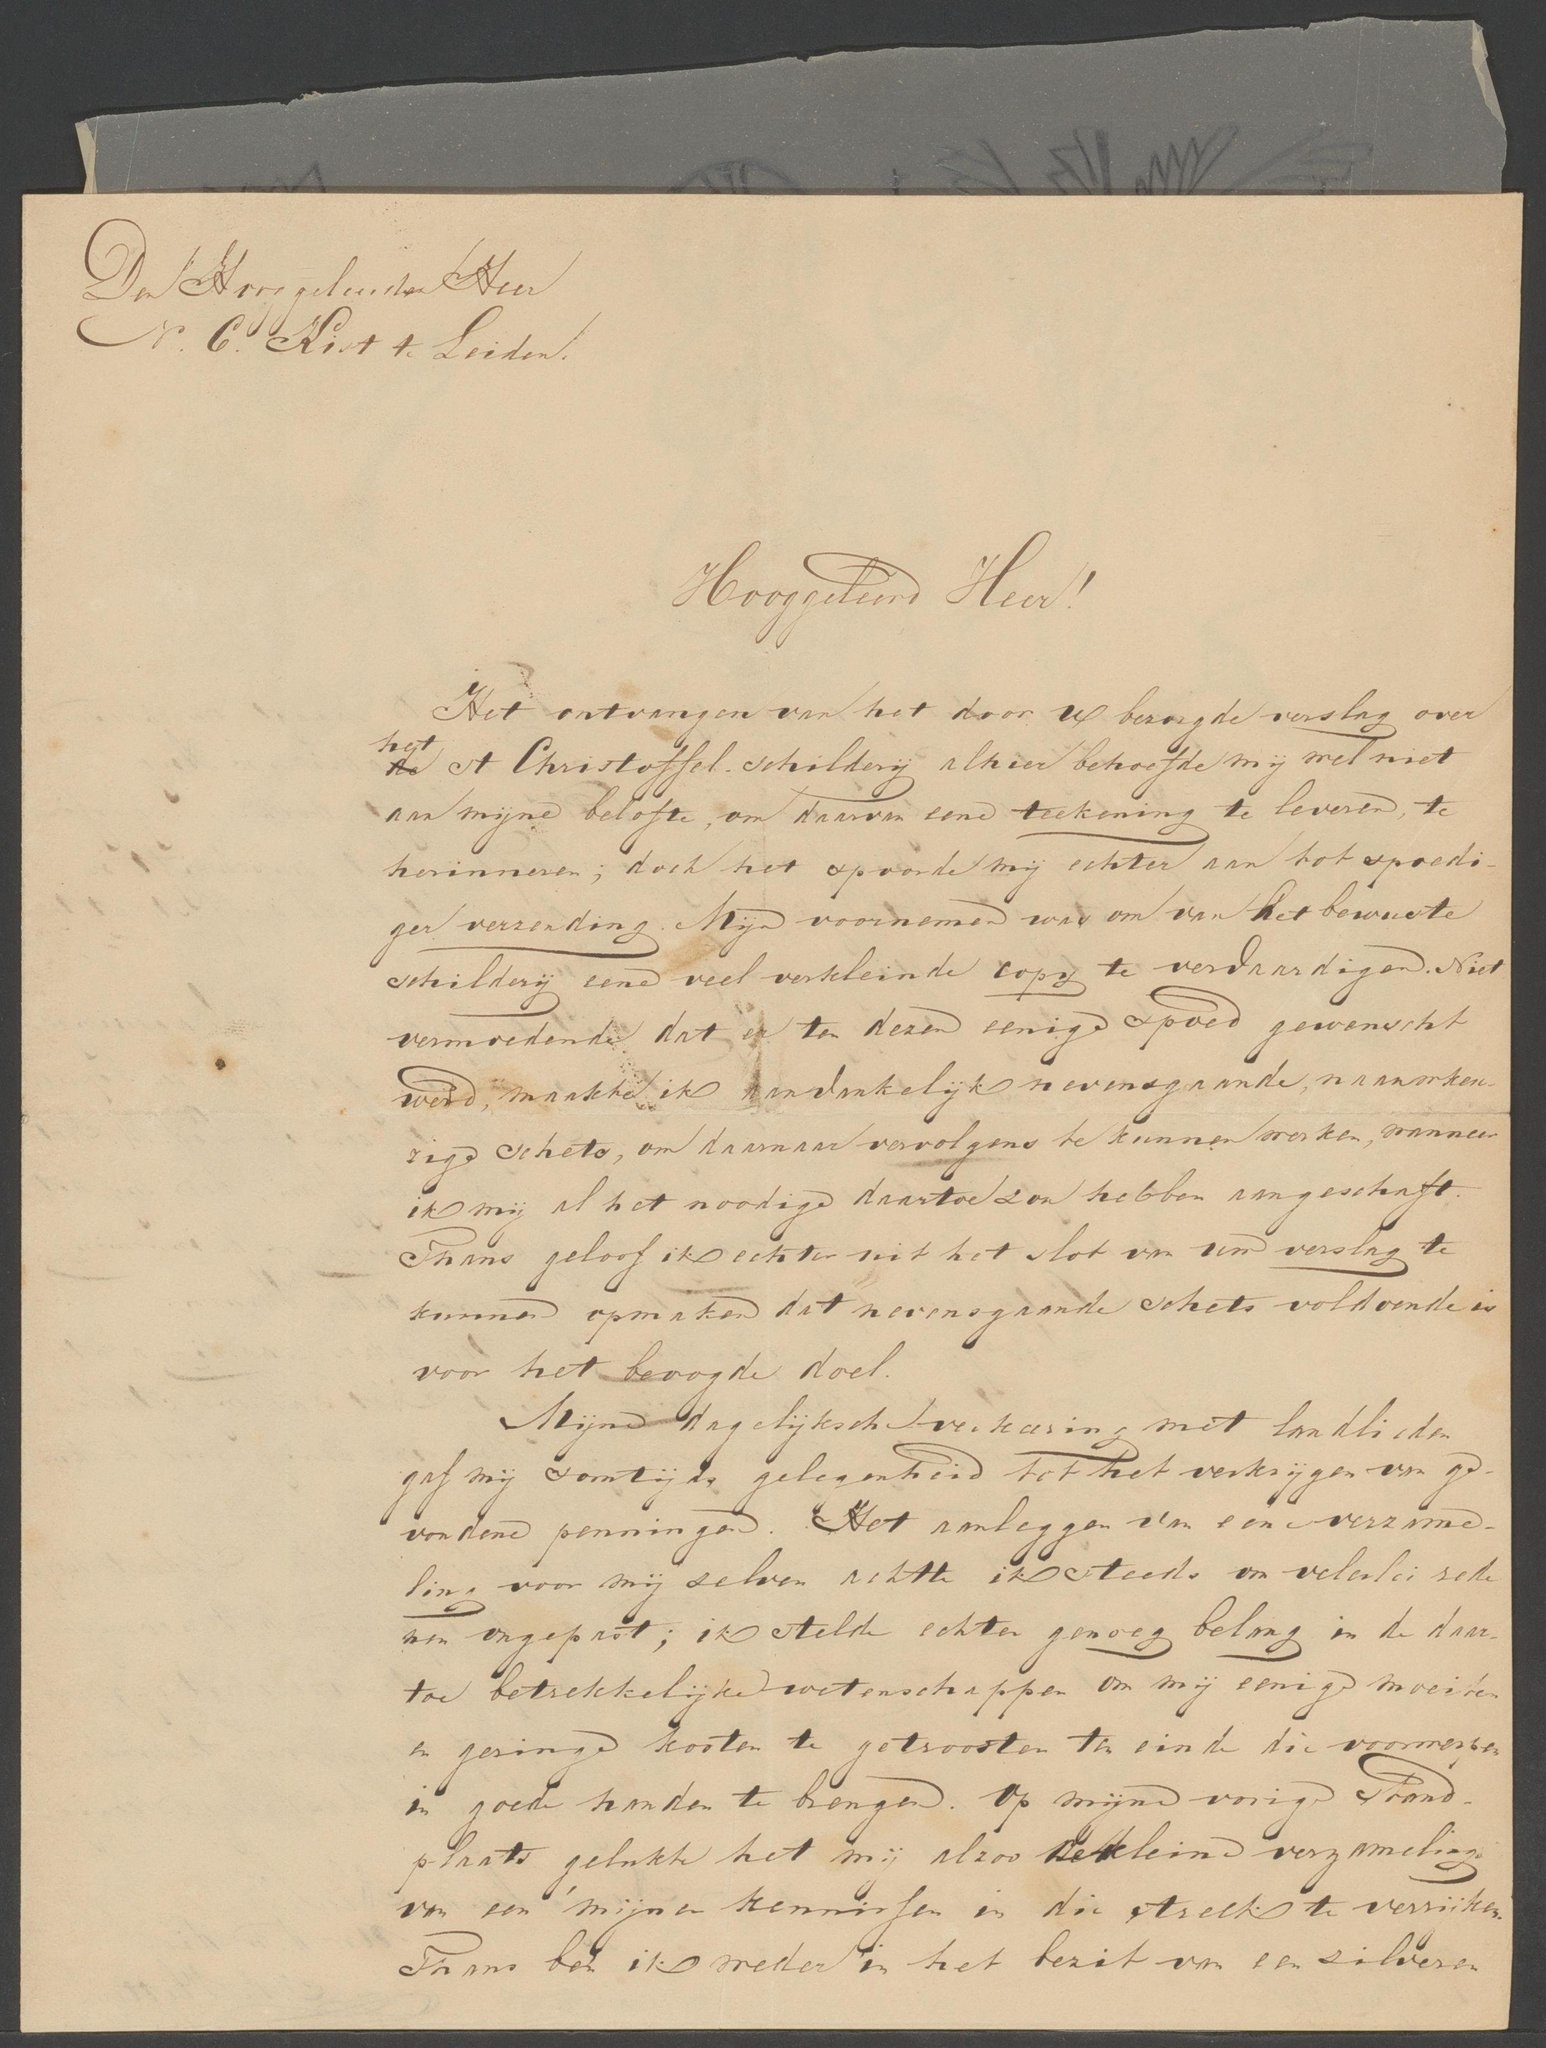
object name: text sheet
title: Muurschildering van Christoffel uit de kerk van Opheusden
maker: Anonymous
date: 1825-1875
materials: paper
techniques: letterpress printing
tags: mural painter, the giant and martyr christophorus; possible attributes: palm-tree (with bunches of dates, or withered), infant christ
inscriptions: stamp: ‘Koninklijk Oudheidkundig Genootschap Amsterdam’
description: Brief over de muurschildering van Christoffel uit de kerk van Opheusden aan de heer Kist. Met een tekening naar de muurschildering van Christoffel uit de kerk van Opheusden. Onderwerpsrubrieken binnen de Atlas Zeden en Gewoonten: Schoone kunsten, Muur- en gewelfschilderingen.